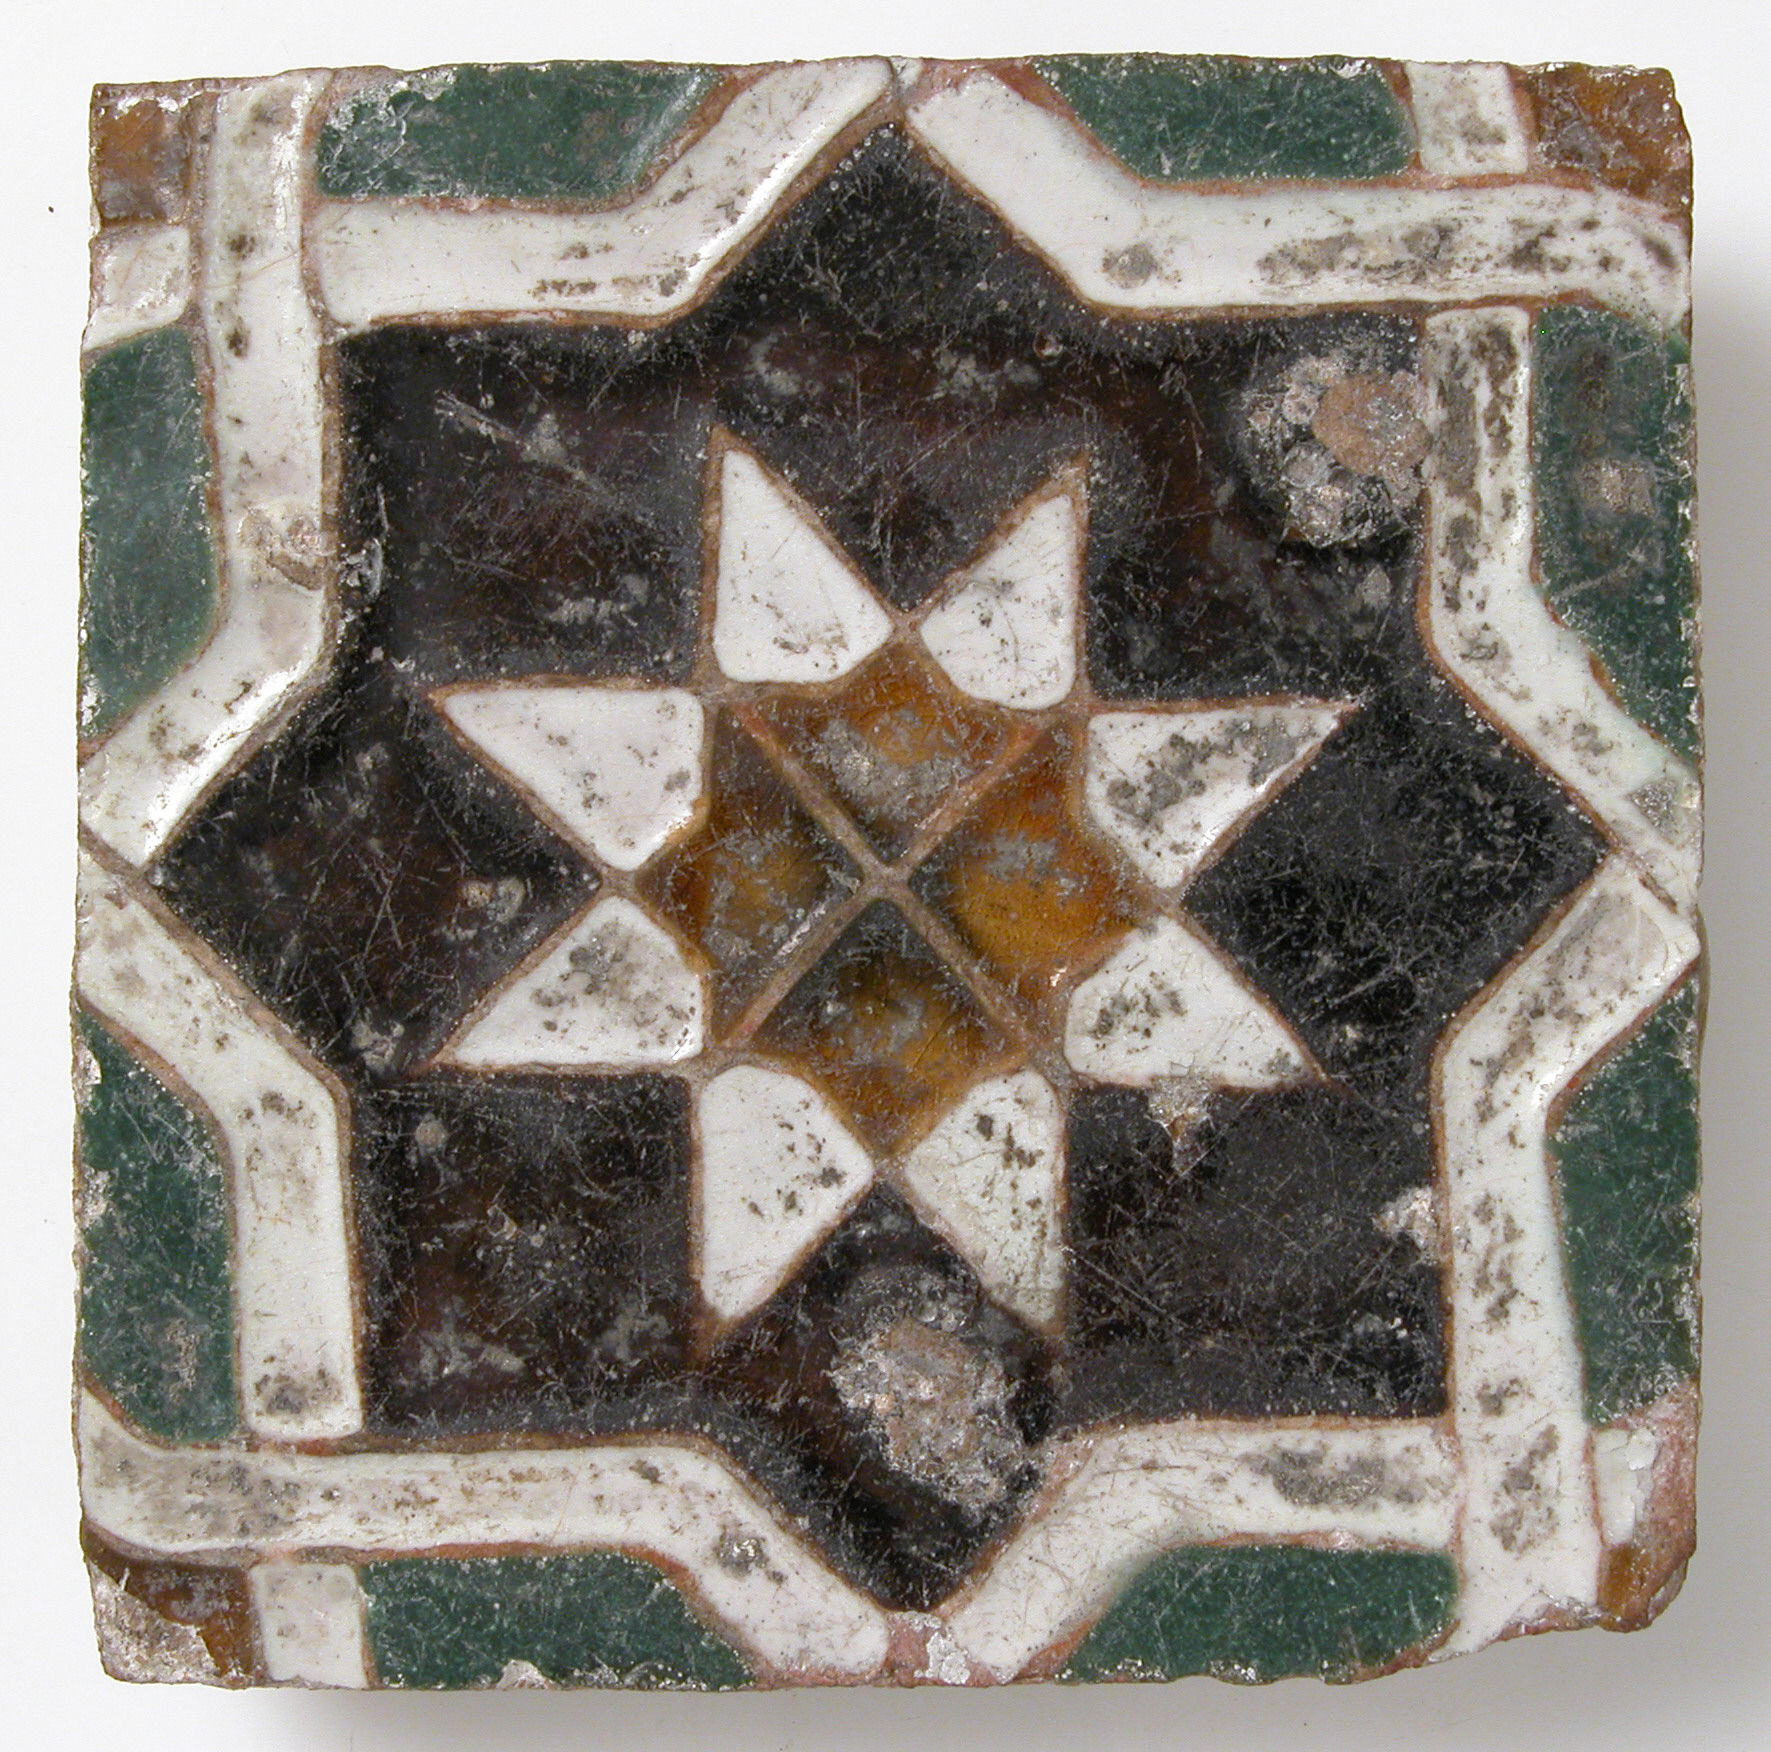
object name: tile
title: Tile with Geometric Design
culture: spanish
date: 1501-1600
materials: earthenware, glaze